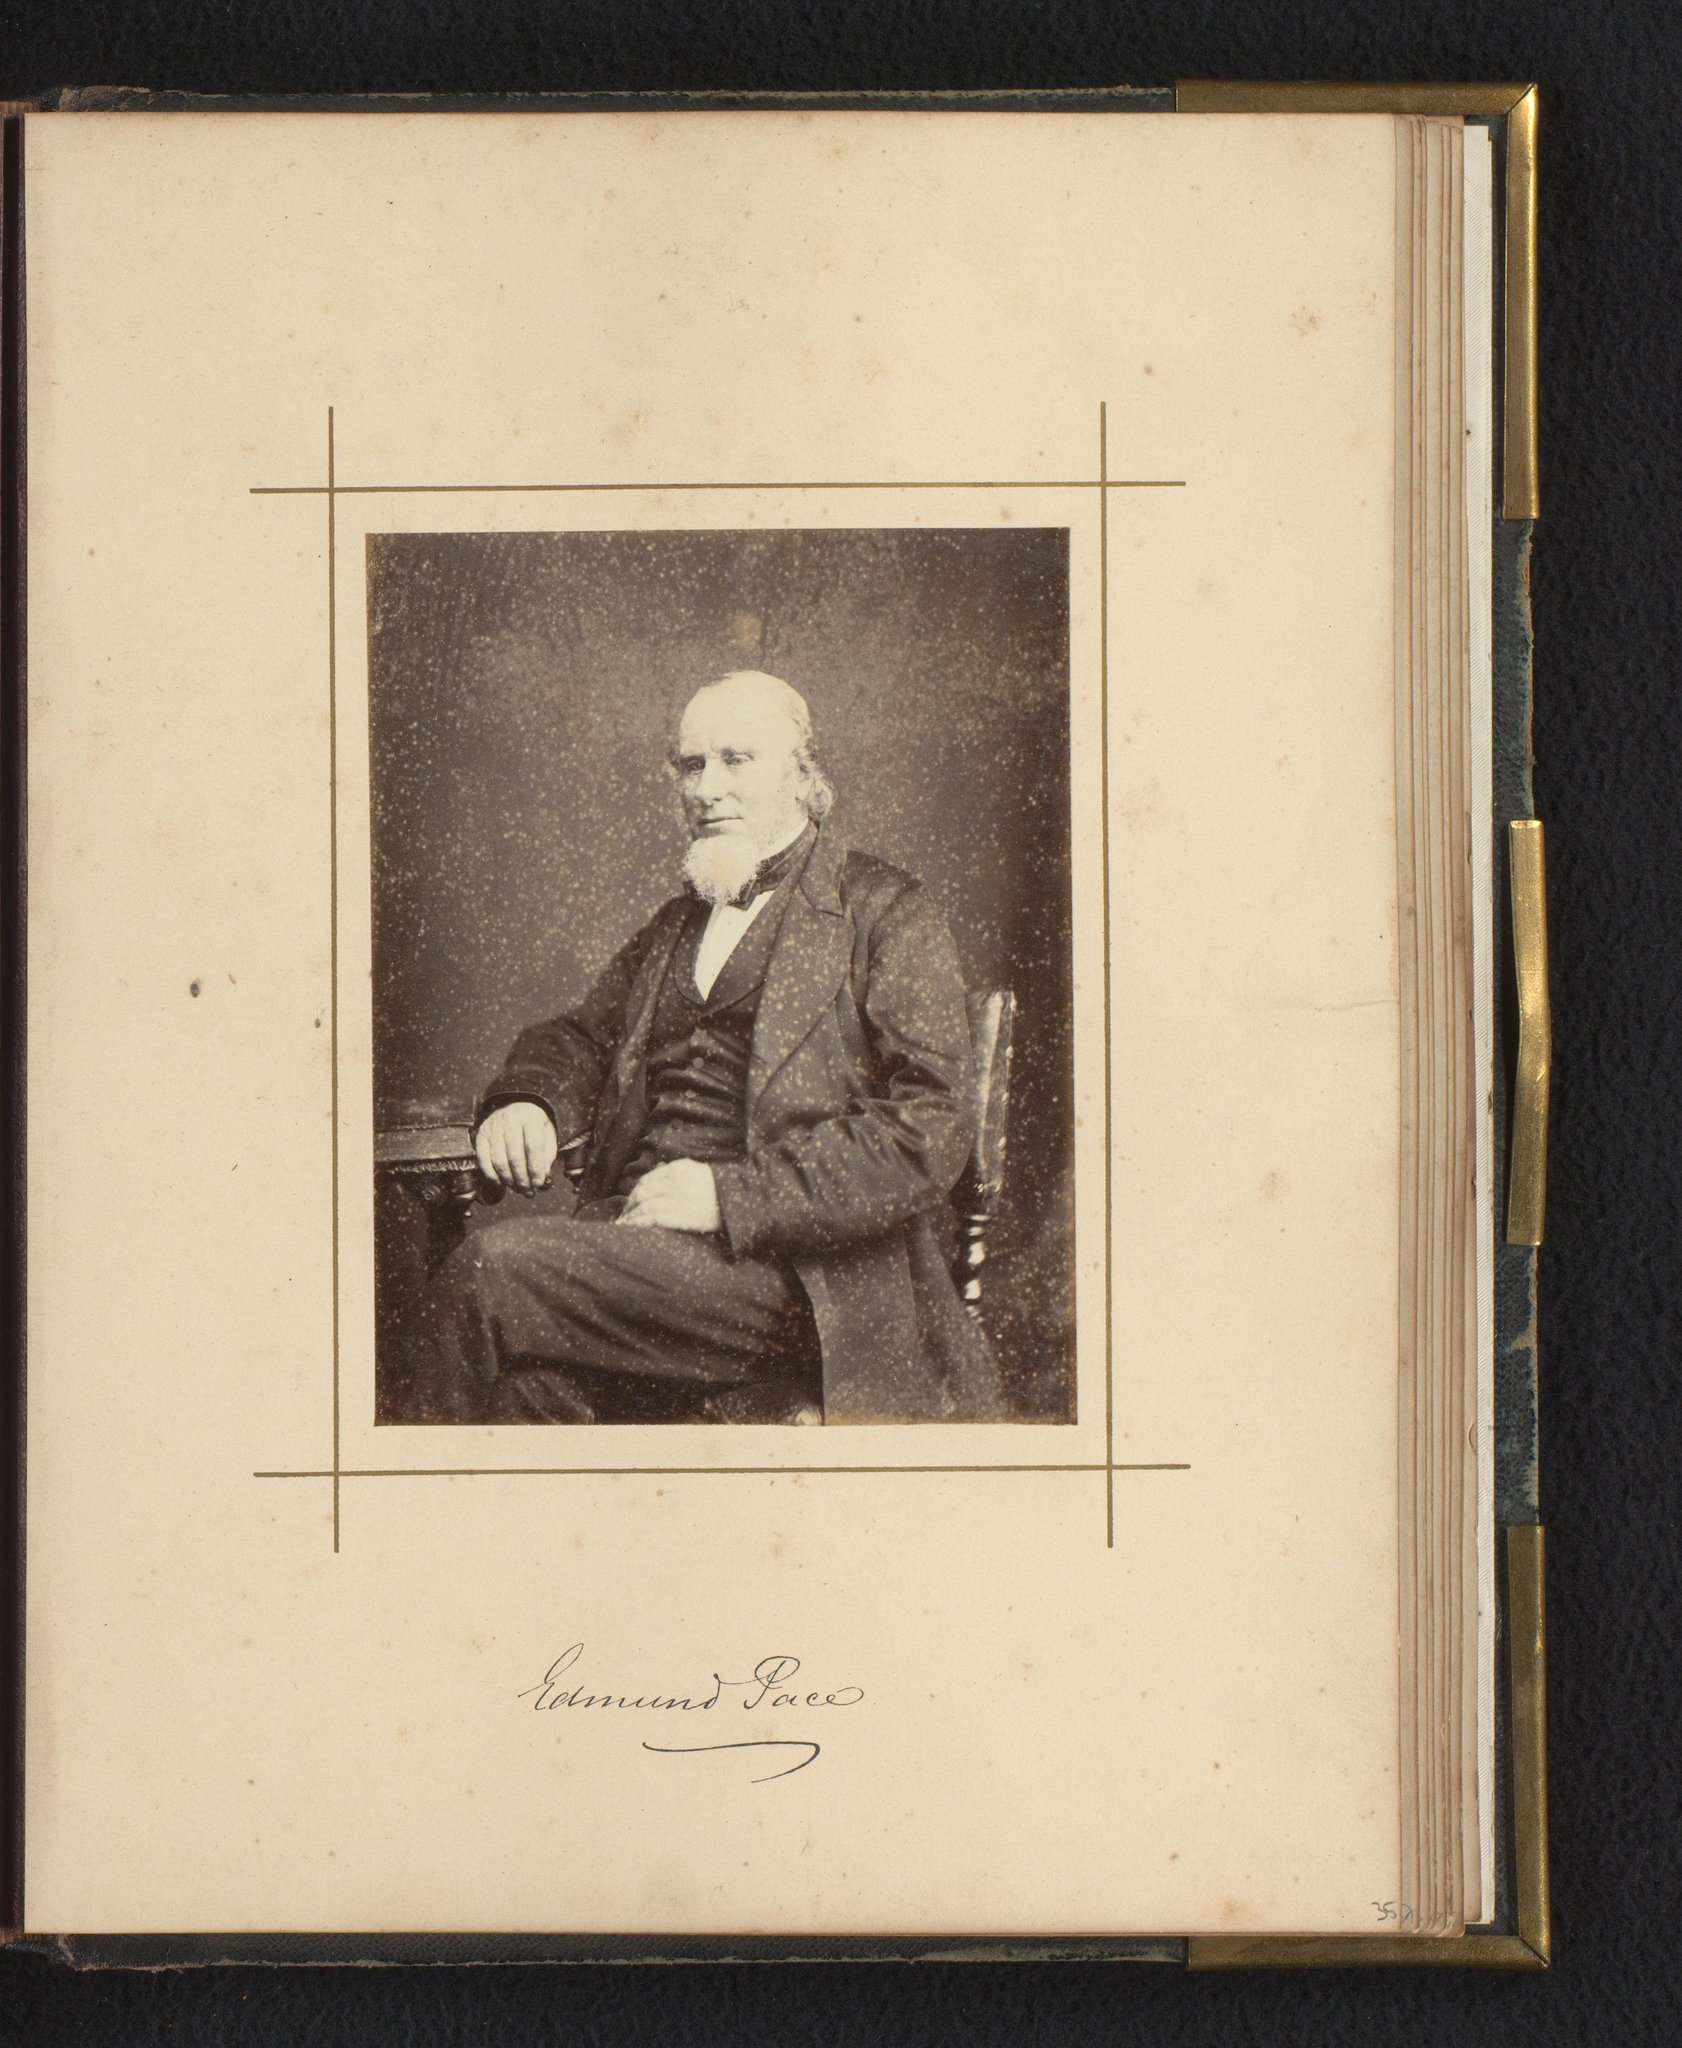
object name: page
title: Portret van Edmund Pace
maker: Anonymous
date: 1866-1871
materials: photographic support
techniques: albumen print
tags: sitting figure, historical persons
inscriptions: name: ‘Edmund Pace’